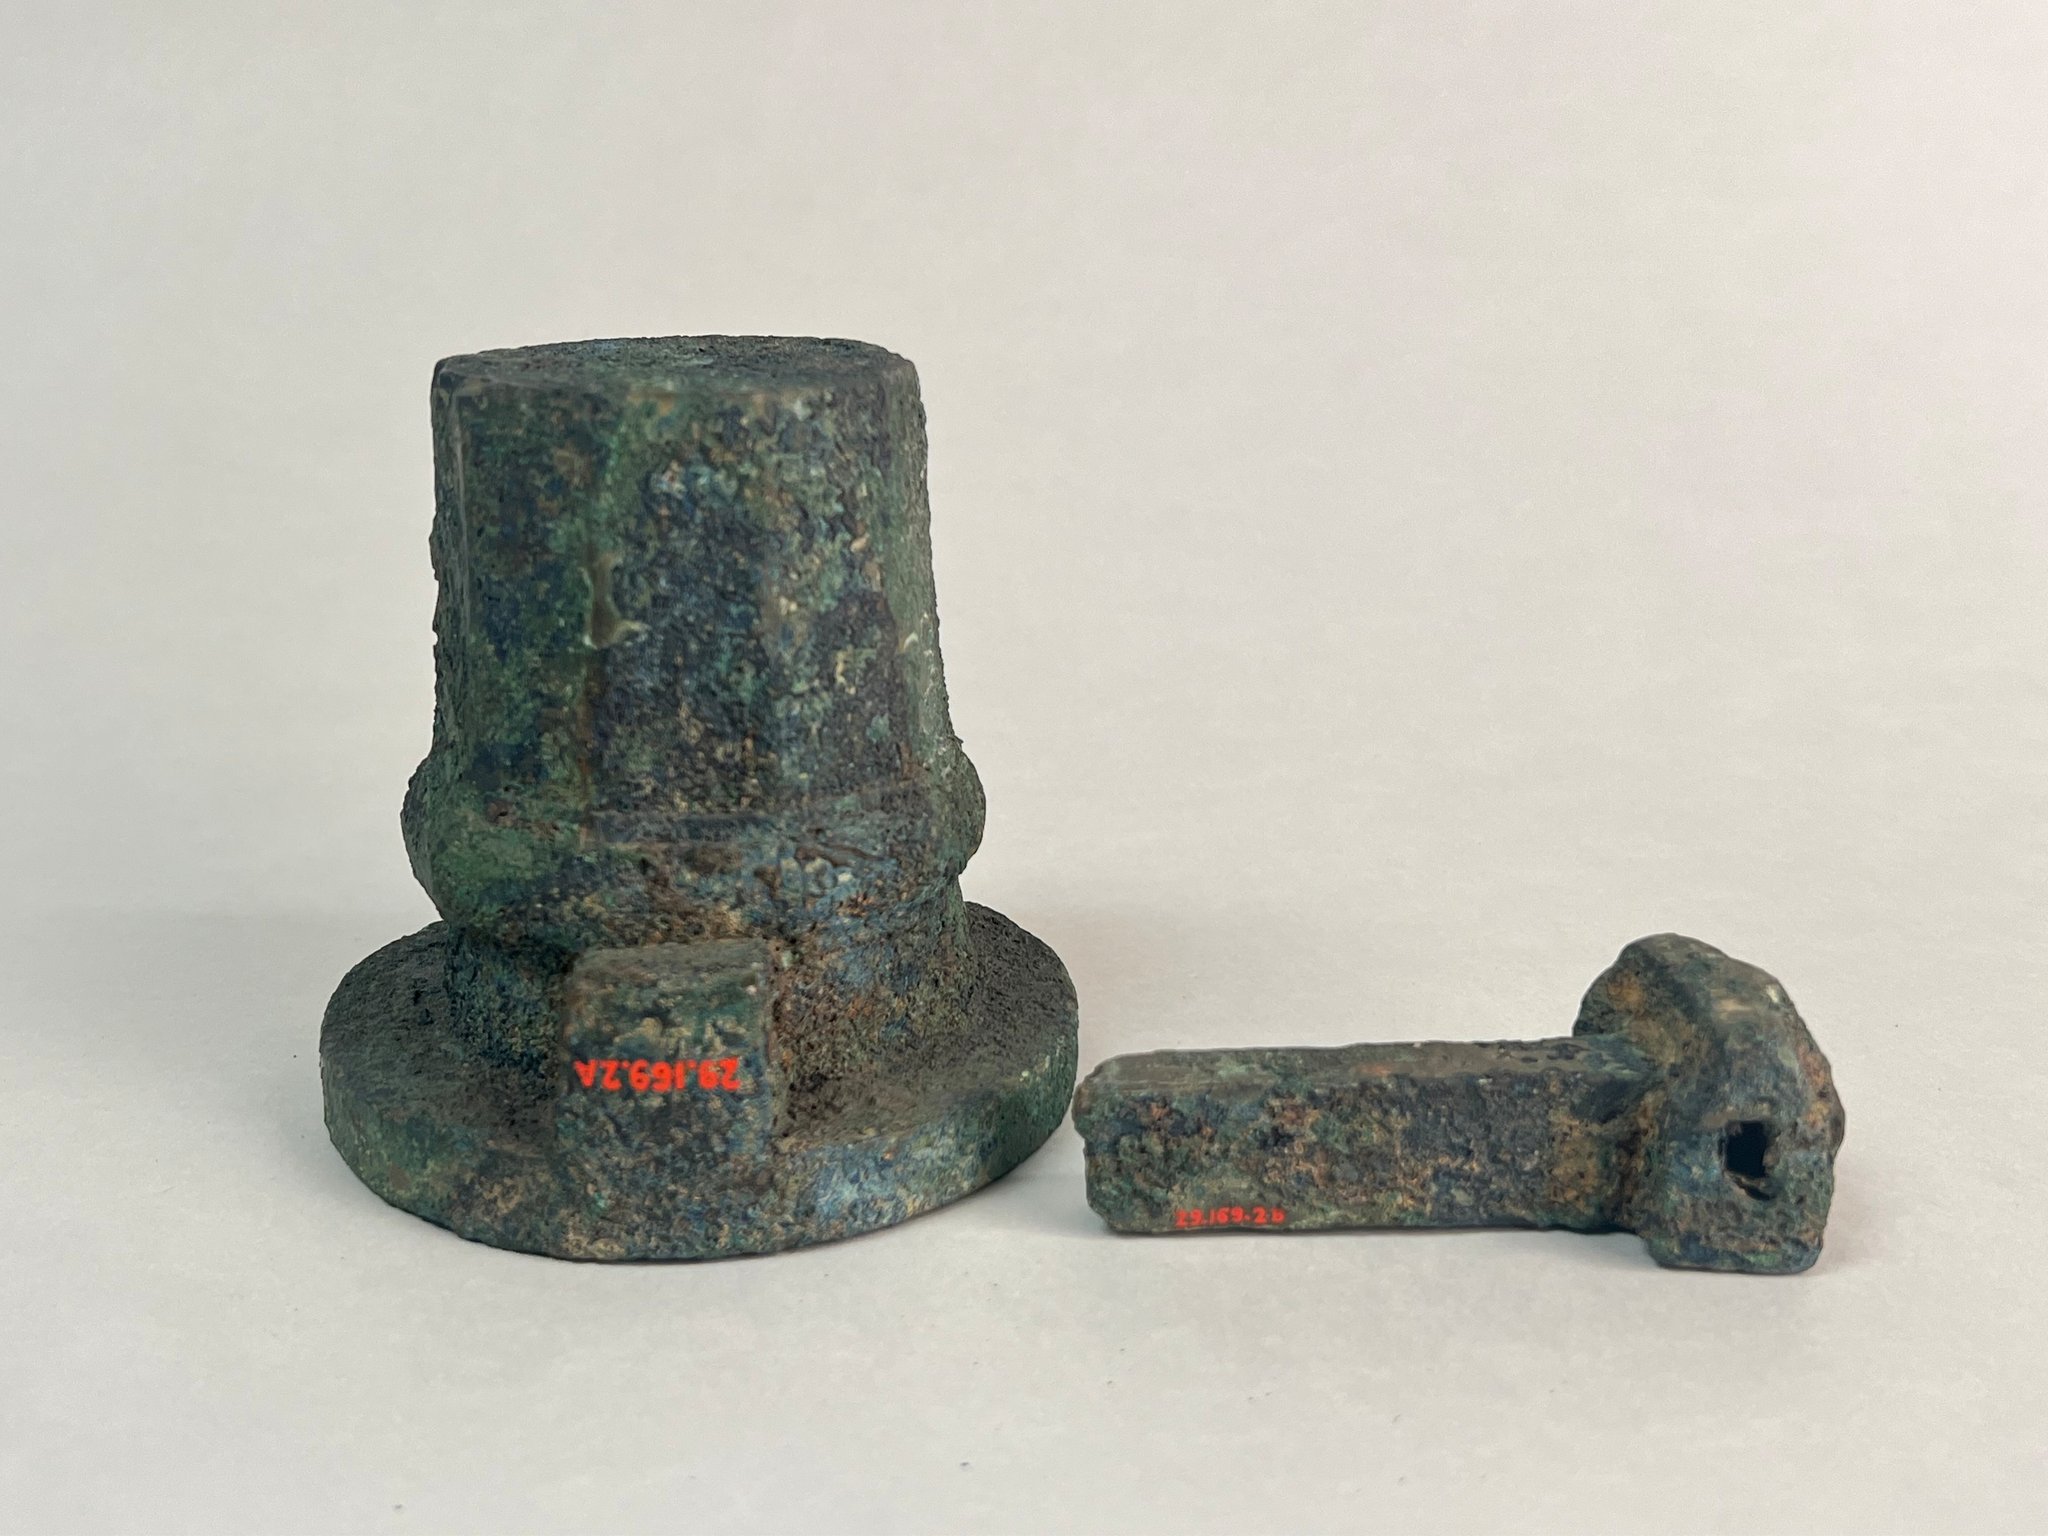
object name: hub with pin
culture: chinese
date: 1046-256 BCE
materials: bronze